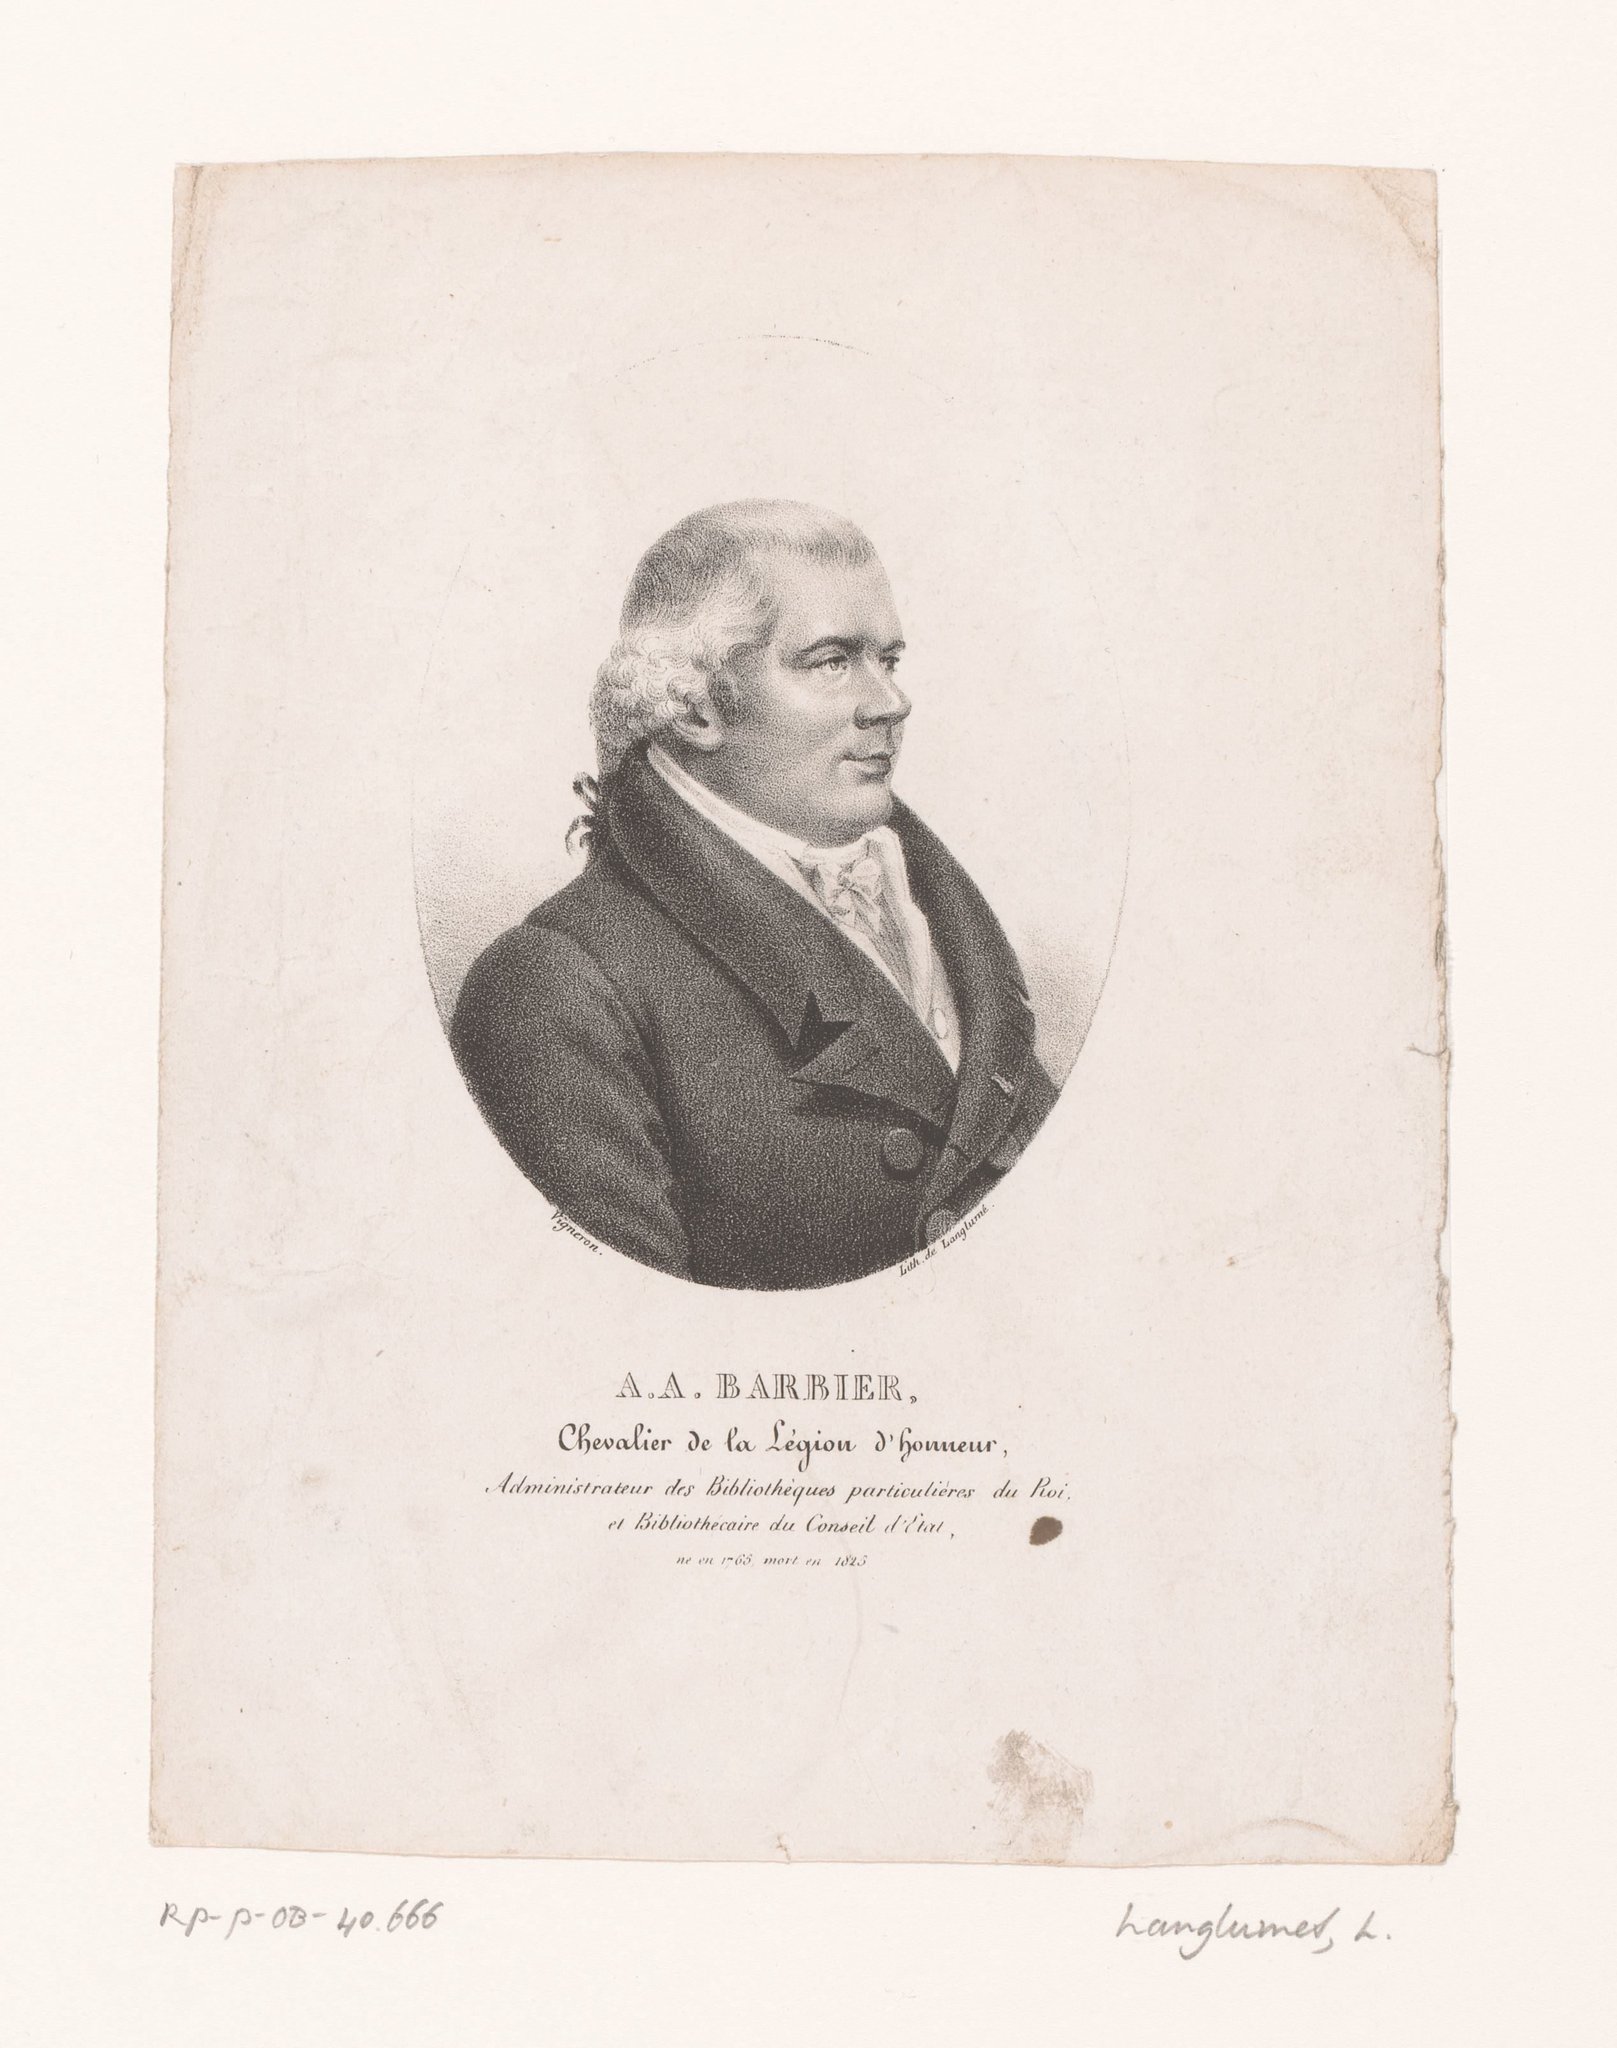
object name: print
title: Portret van Antoine-Alexandre Barbier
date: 1820-1830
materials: paper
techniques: lithograph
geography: paris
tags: paris, historical persons